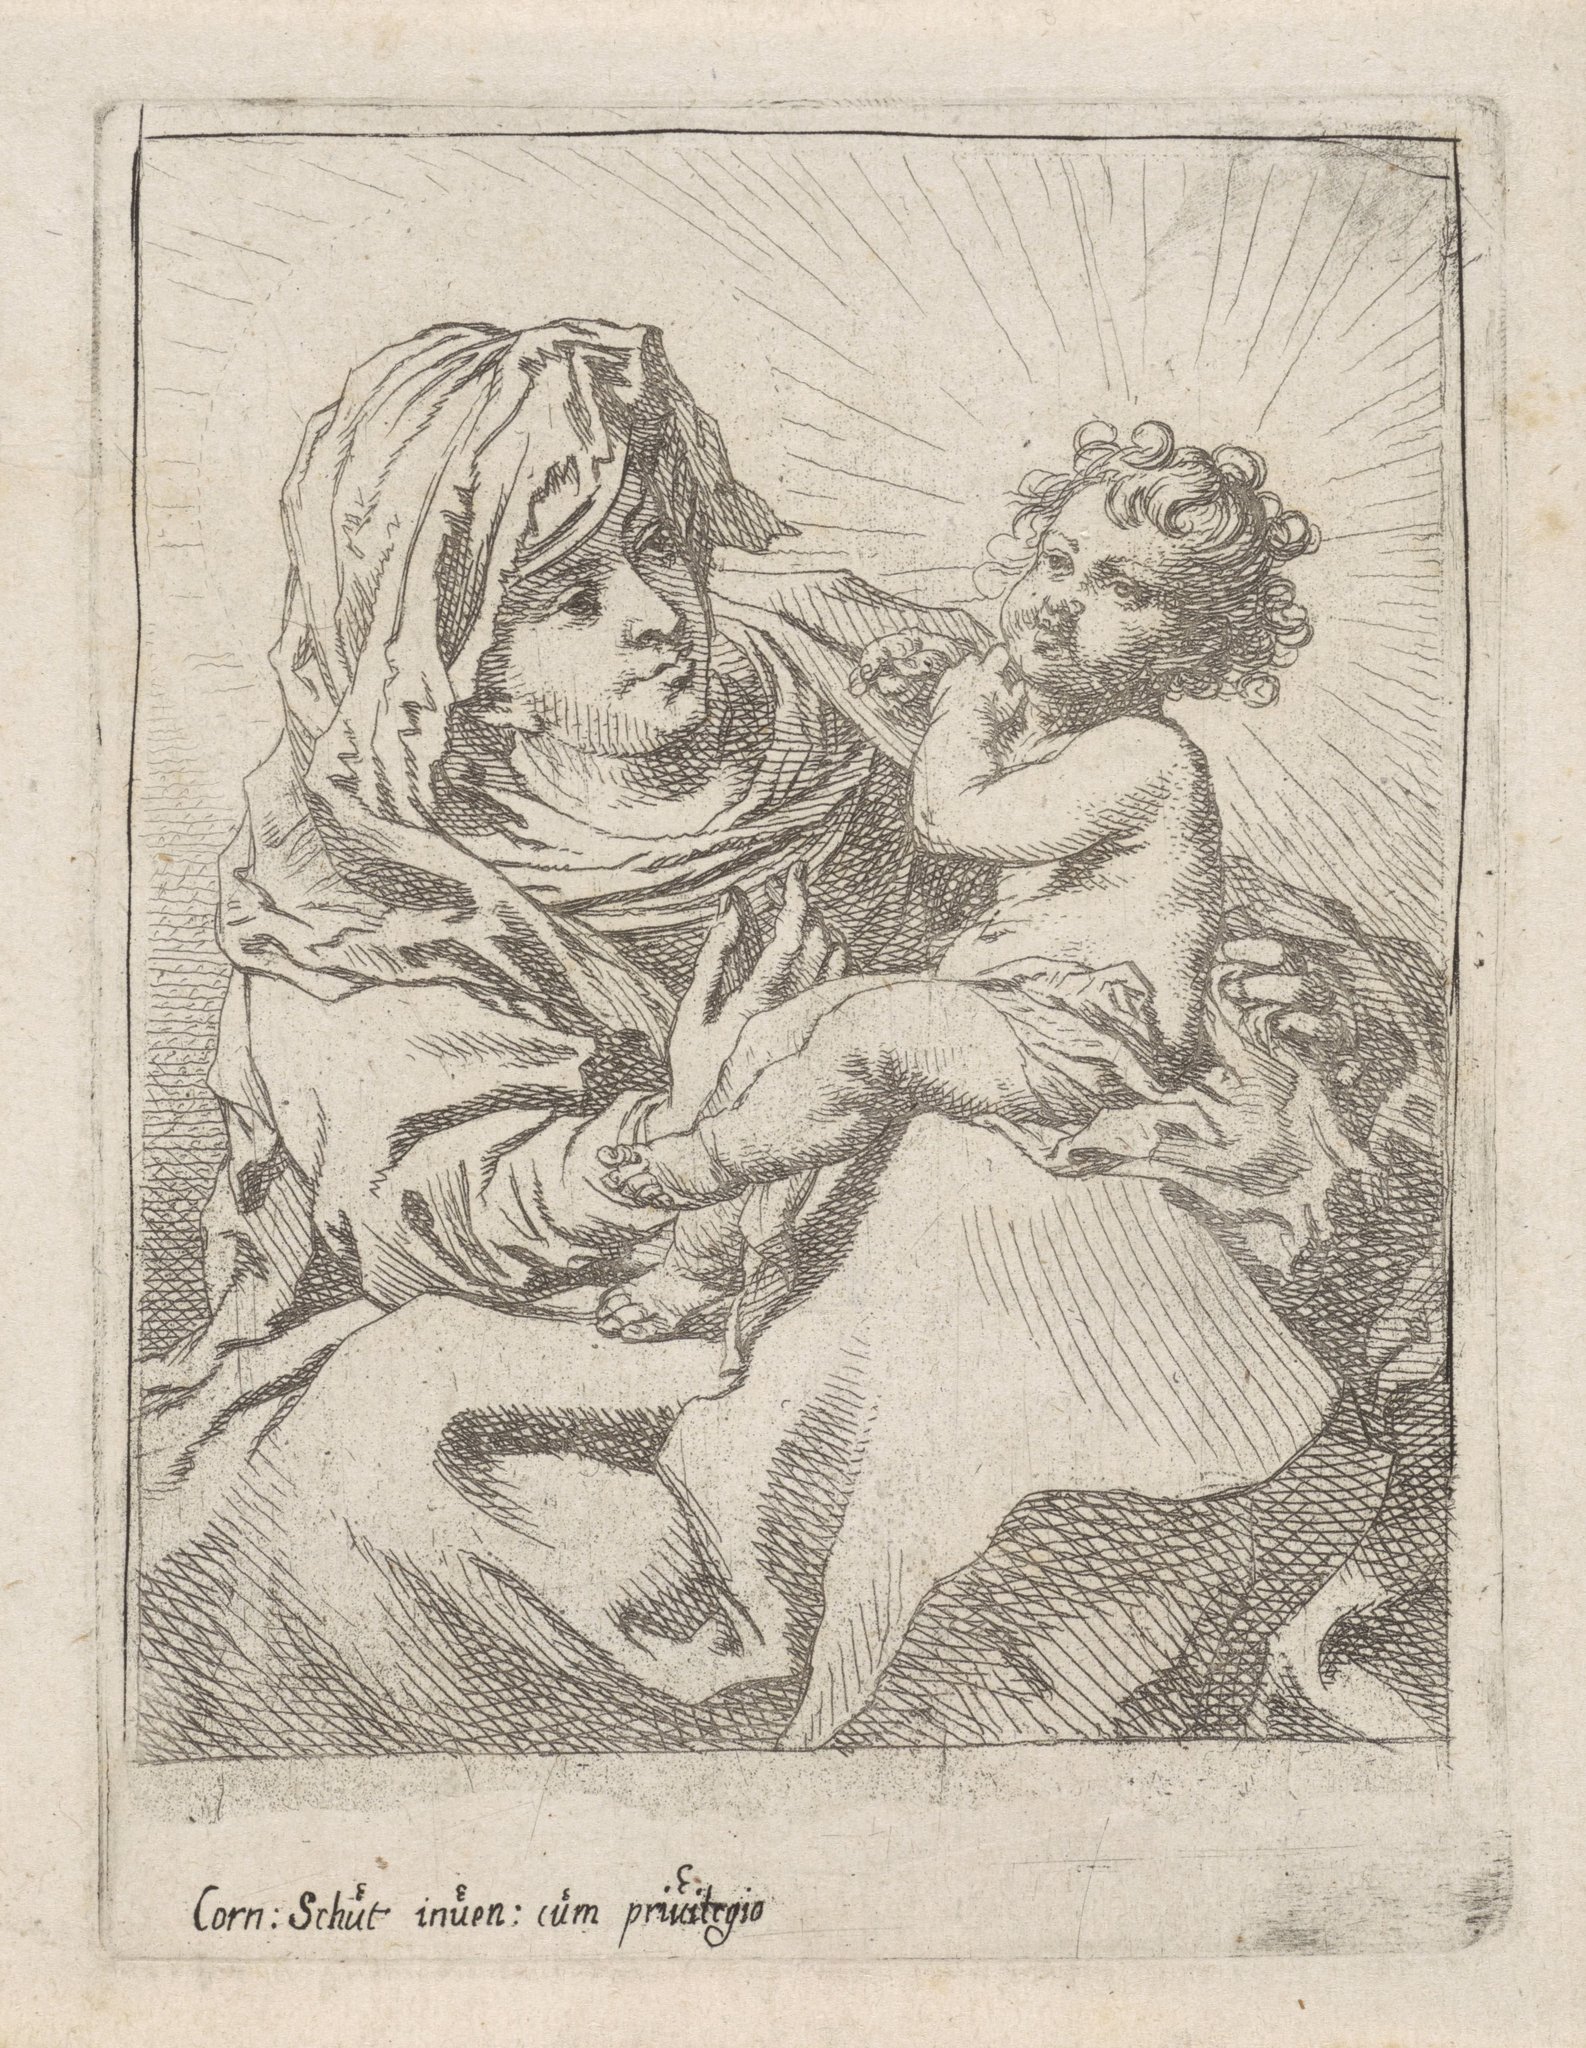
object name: print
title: Madonna met kind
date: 1618-1655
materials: paper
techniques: etching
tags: madonna: mary sitting or enthroned, the christ-child in her lap (or in front of her bosom) (mary sometimes represented half-length)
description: Het Christuskind zit op Maria's knie; hij steunt zichzelf tegen haar schouder.